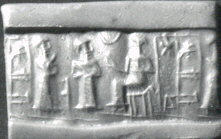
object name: cylinder seal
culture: isin-larsa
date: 2000-1750 BCE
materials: mineral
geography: mesopotamia